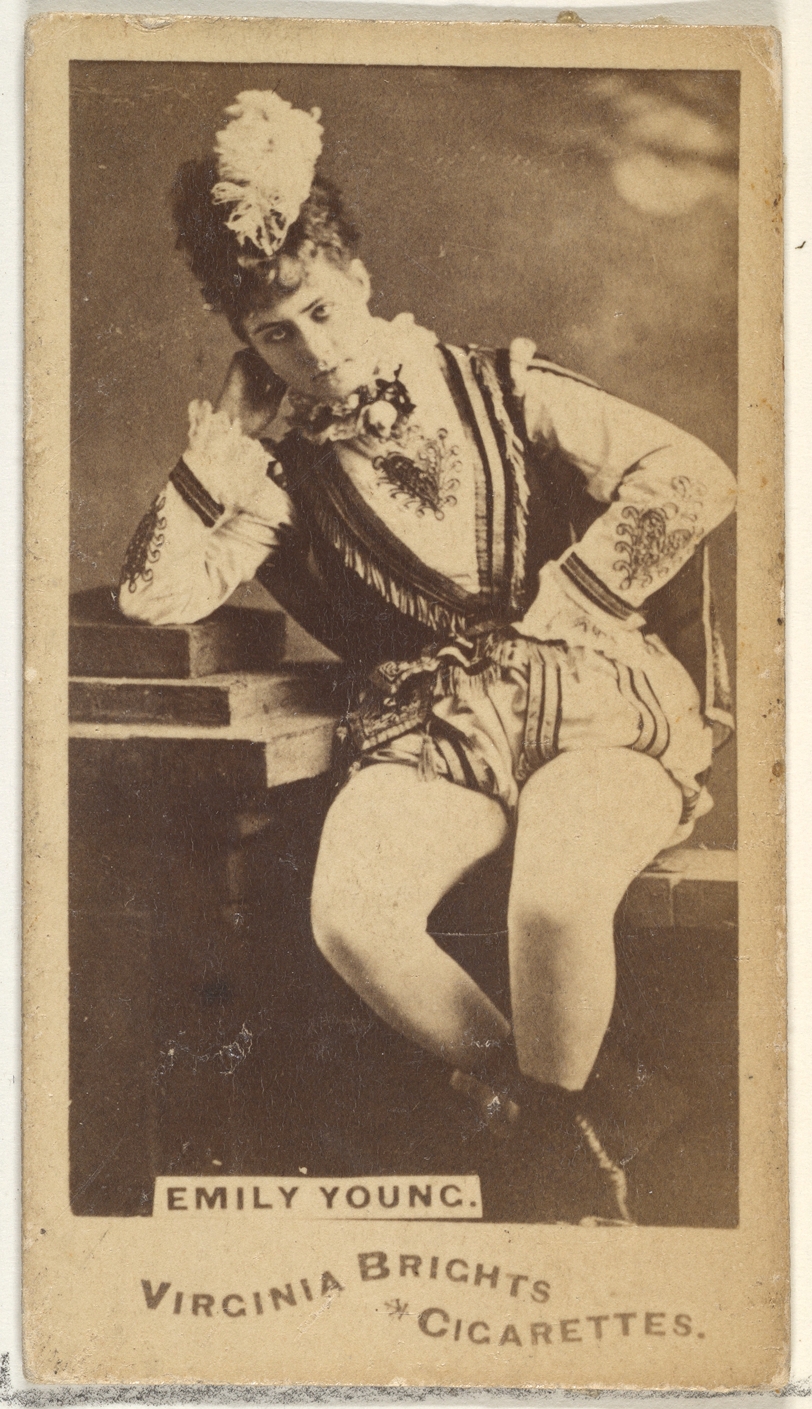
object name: photograph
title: Emily Young, from the Actors and Actresses series (N45, Type 1) for Virginia Brights Cigarettes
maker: allen & ginter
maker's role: publisher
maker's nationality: american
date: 1888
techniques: albumen silver print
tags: portraits,women,actresses